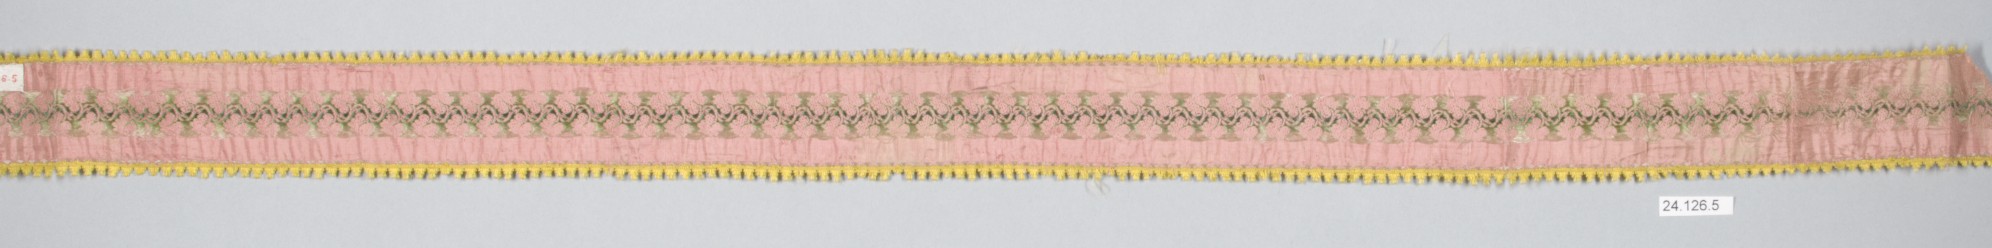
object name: ribbon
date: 1701-1800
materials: silk